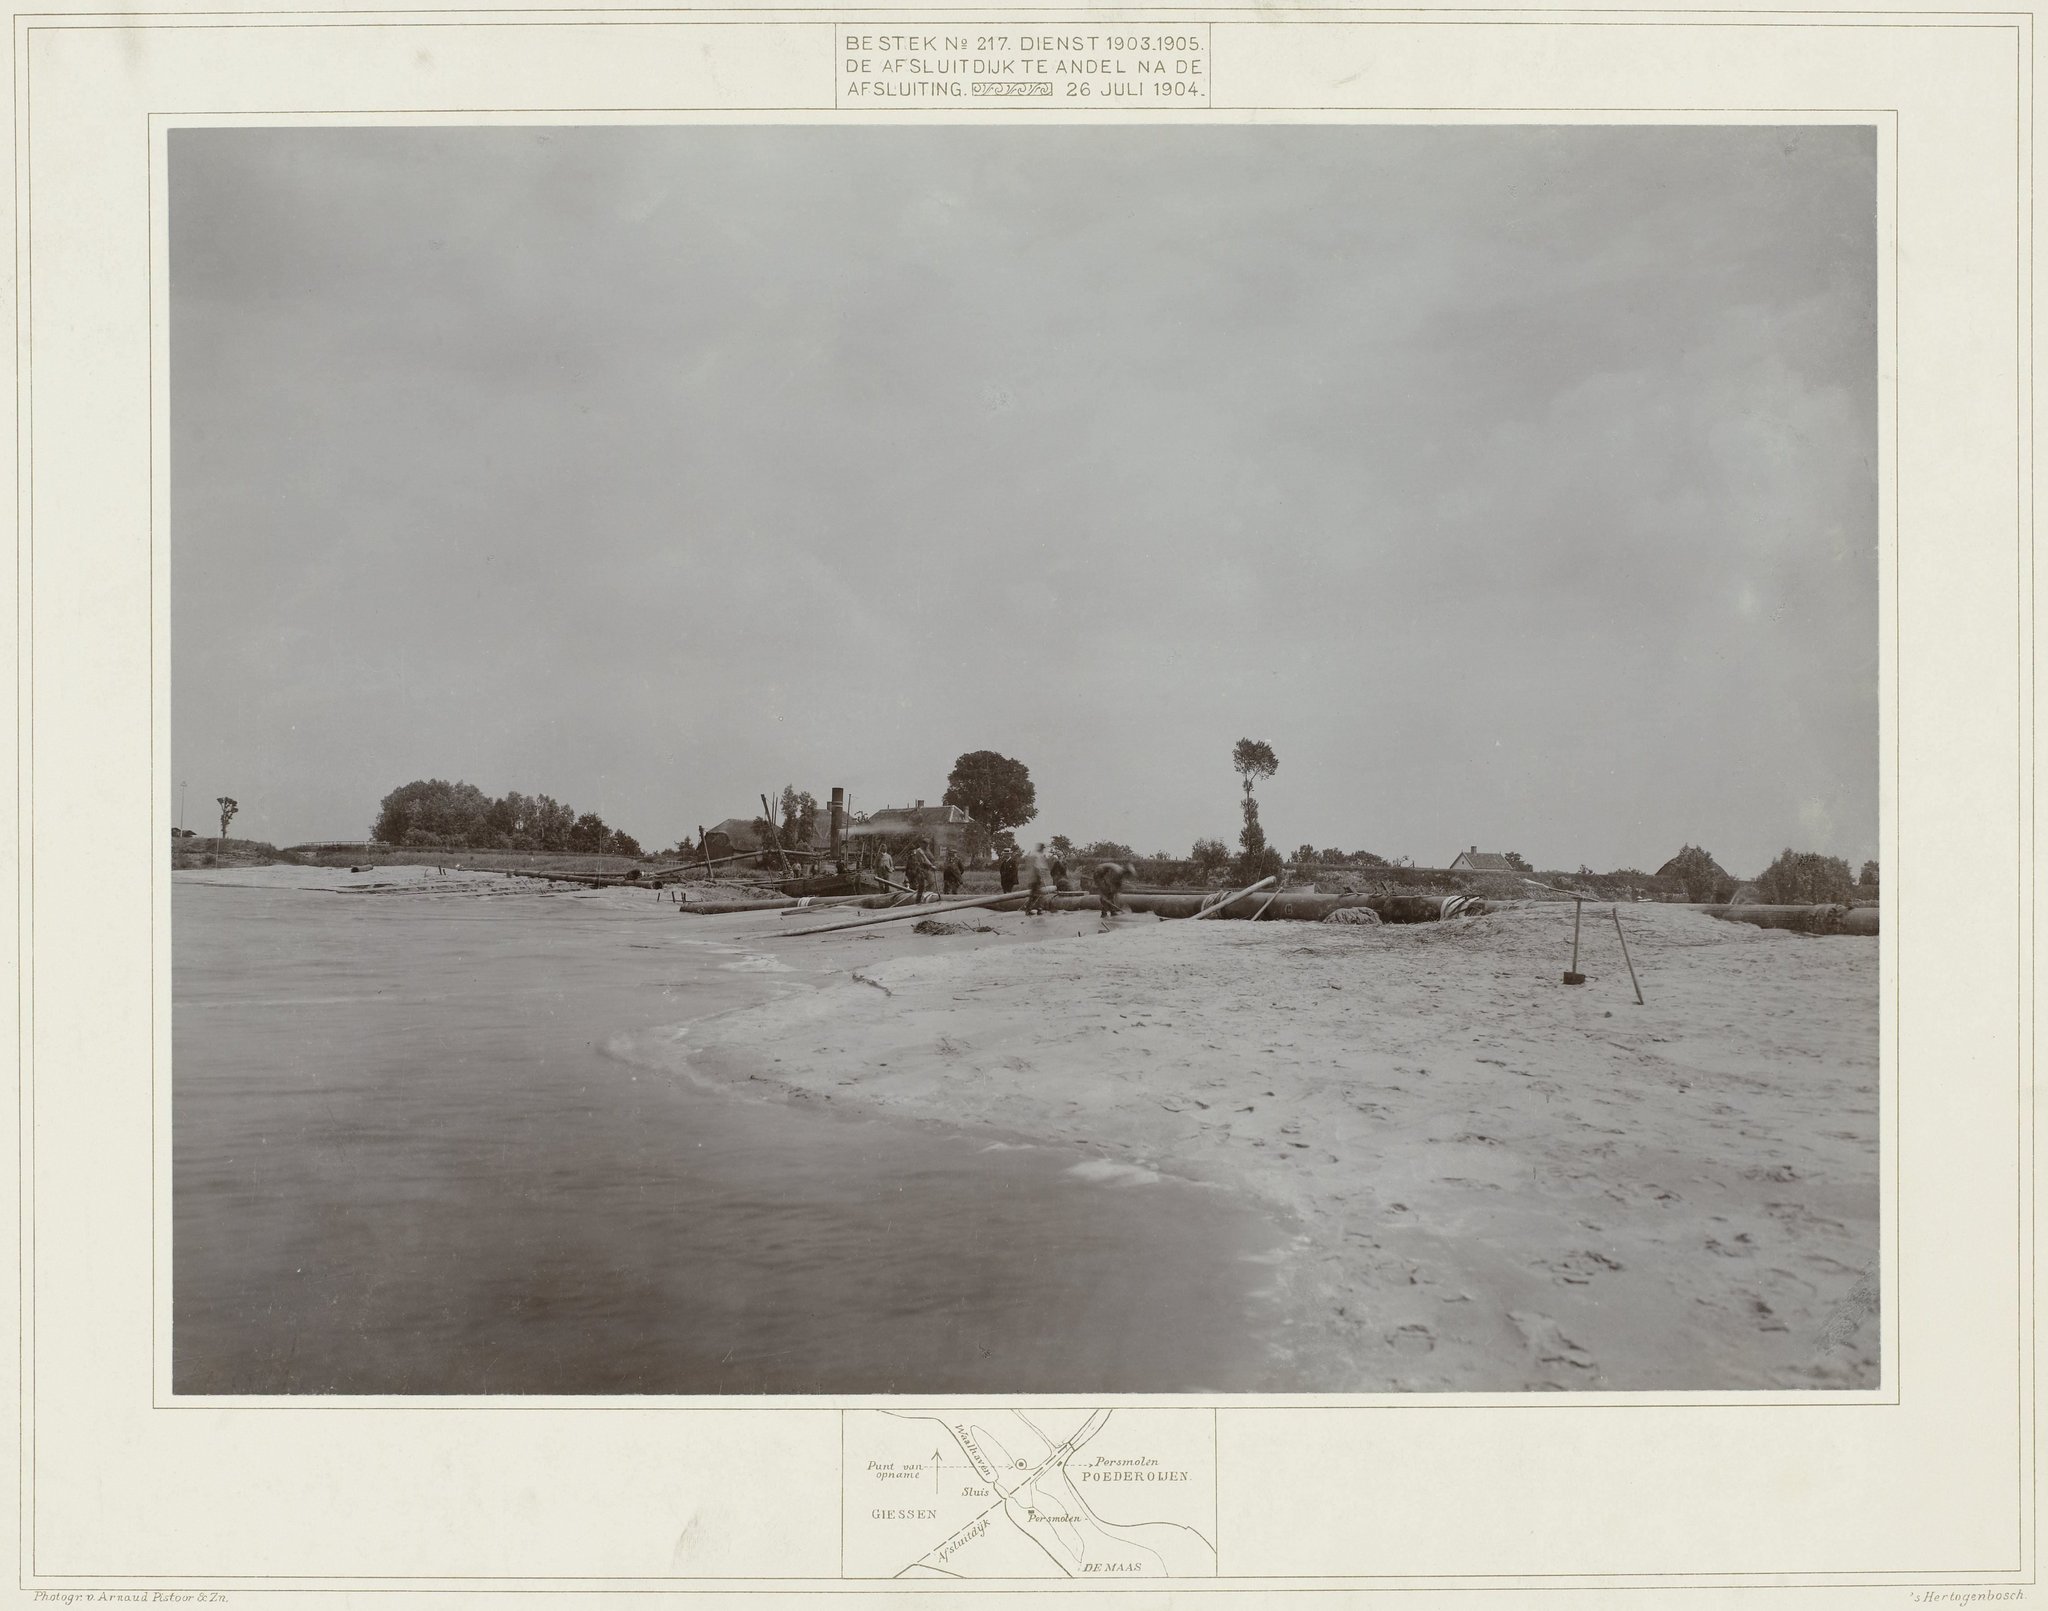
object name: photograph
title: Bestek nr. 217, dienst 1903, 1905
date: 1904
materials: cardboard, paper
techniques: photography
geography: den bosch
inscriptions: date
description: Foto op karton van waterbouwkundige werken (ten behoeve van de scheiding tussen maas en waal). Tekst boven de foto, onder de foto een situatiekaartje. Opschrift; b.: 'De Afsluitdijk te Andel na de afsluiting 26 juli, 1904. Gesigneerd en gedateerd.